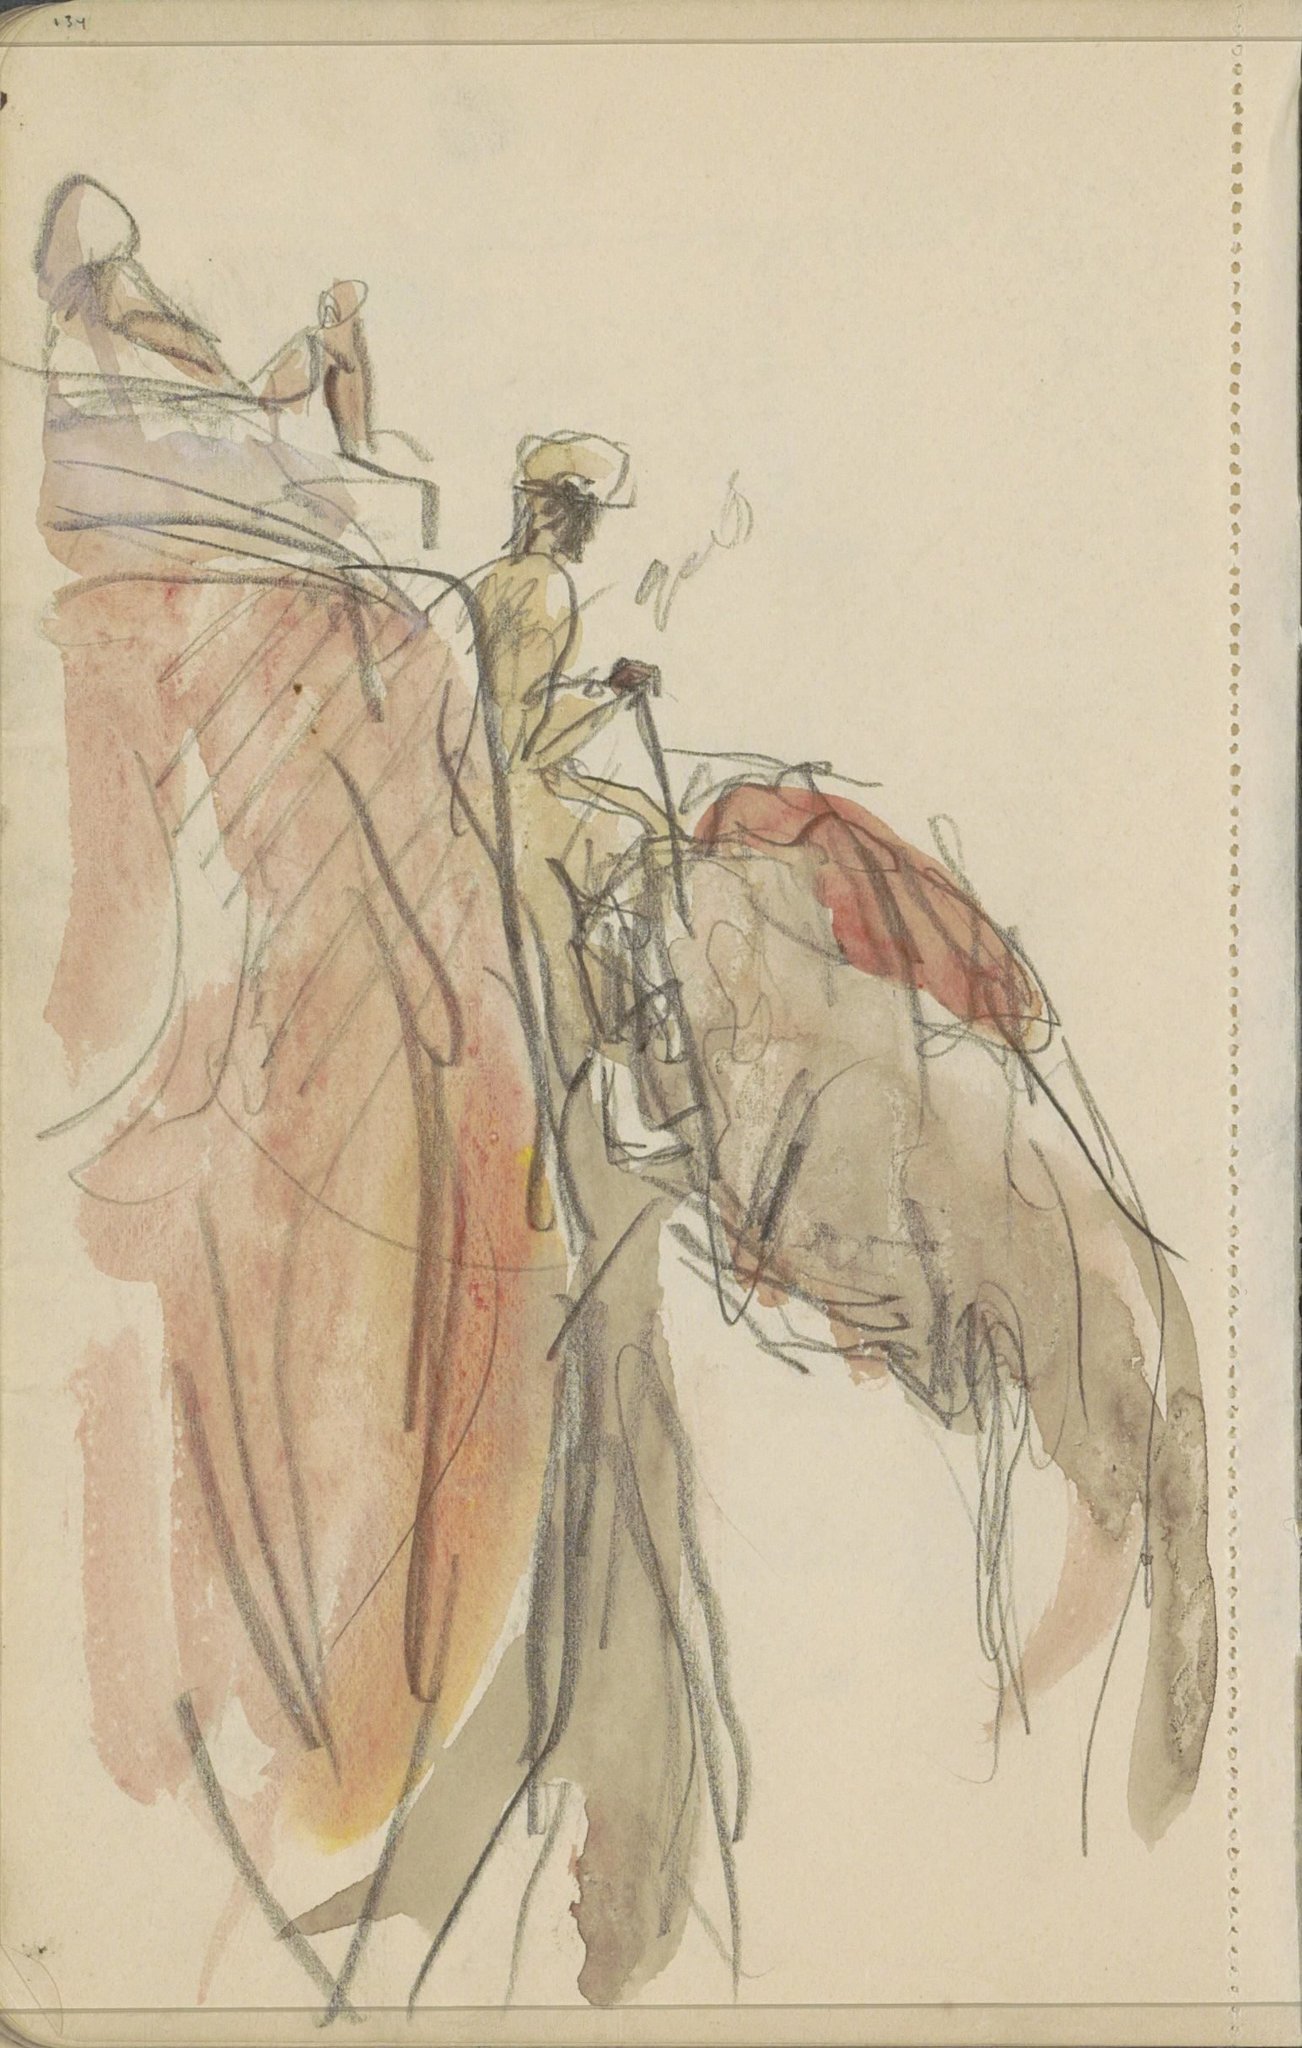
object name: sketchbook leaf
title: Indiër op een olifant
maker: marius bauer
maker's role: draughtsman, print maker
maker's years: 1867-1932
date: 1924-1925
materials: paper, pencil, watercolor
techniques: brush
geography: india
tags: sitting figure, asiatic races and peoples: indians, trunked animals: elephant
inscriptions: kleurnotitie, handgeschreven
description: Pagina 134 uit een schetsboek met 87 bladen.